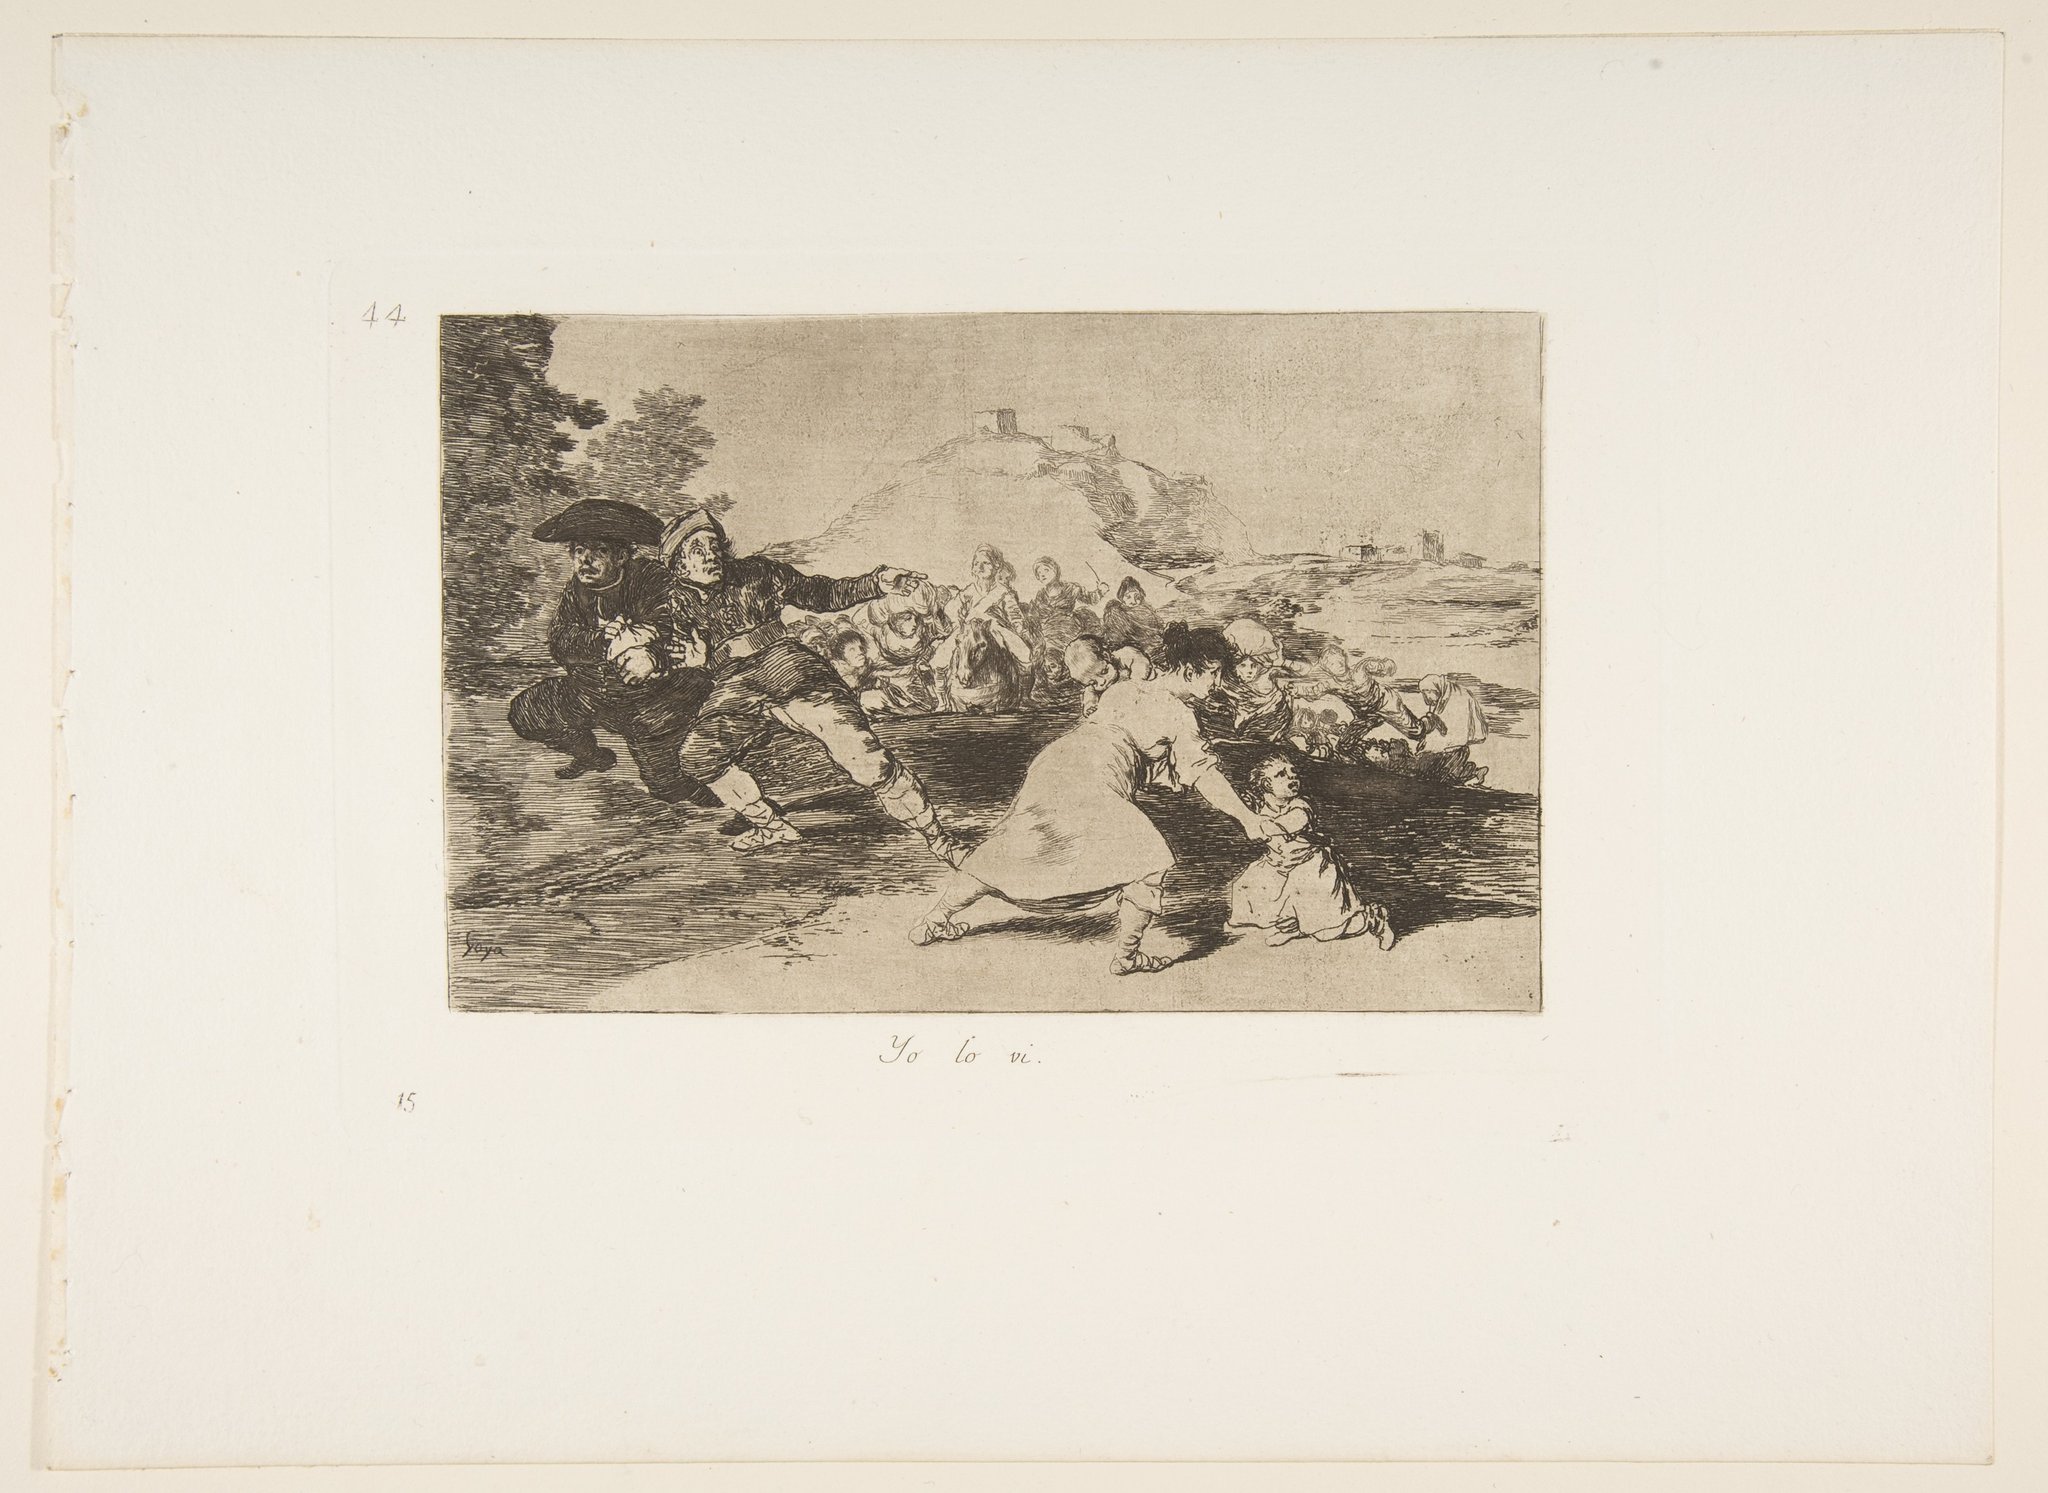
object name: print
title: Plate 44 from "The Disasters of War" (Los Desastres de la Guerra): 'I saw it' (Yo lo vi)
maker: goya (francisco de goya y lucientes)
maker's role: artist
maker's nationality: spanish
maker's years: 1746-1828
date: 1810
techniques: engraving, drypoint, etching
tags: children,men,women